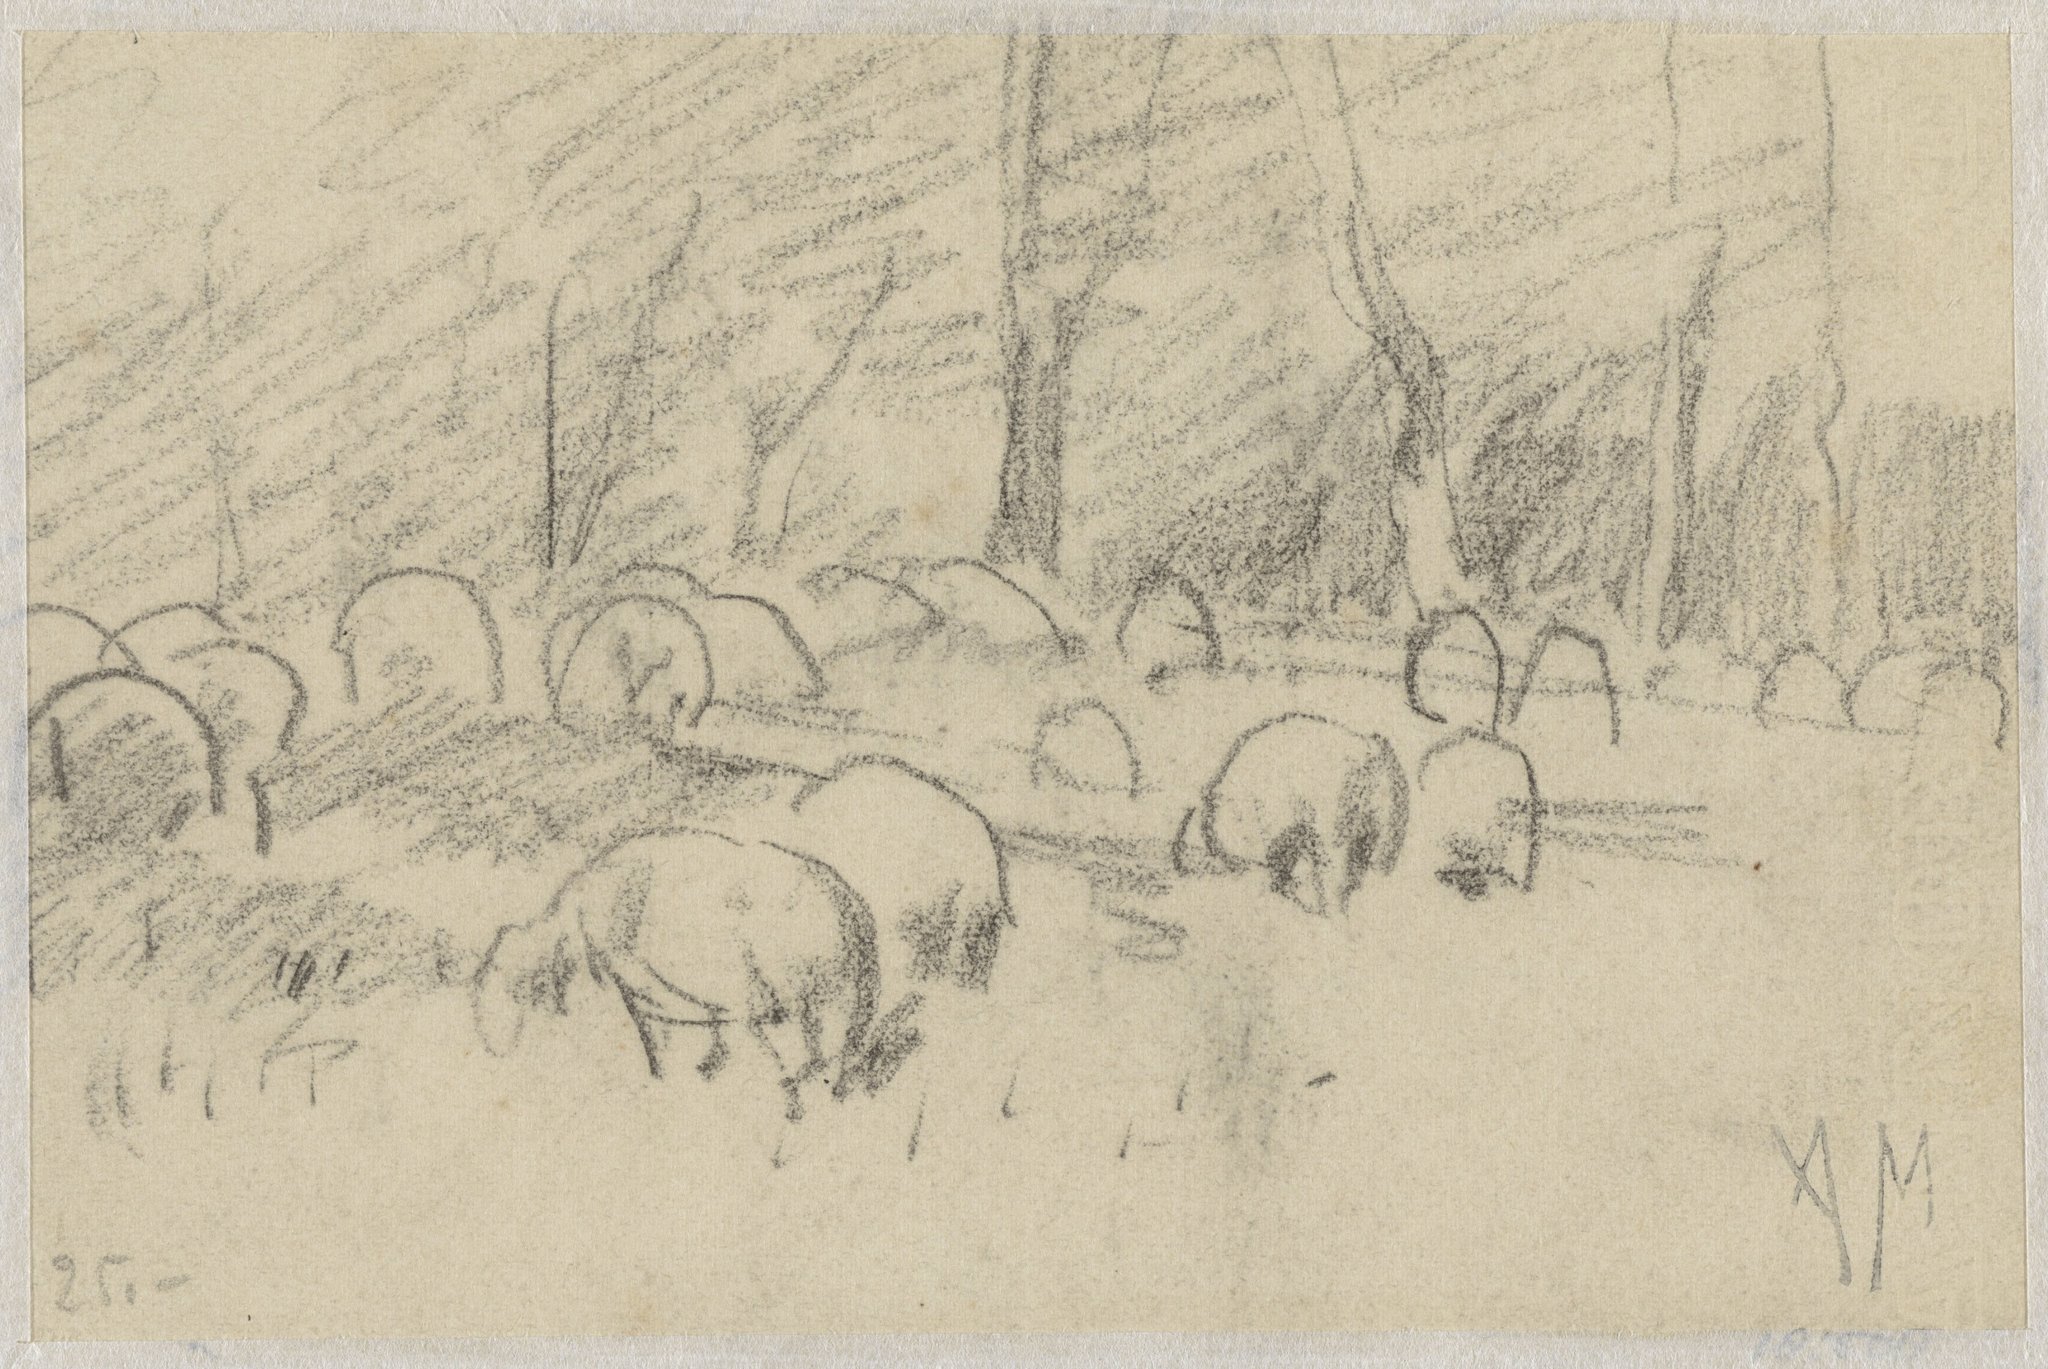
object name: drawing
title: Strand met figuren en boten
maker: anton mauve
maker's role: draughtsman, painter, print maker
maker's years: 1838-1888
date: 1848-1888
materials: chalk, paper